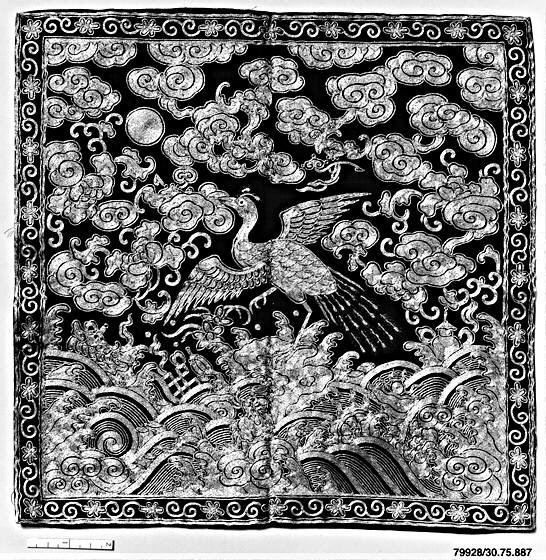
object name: rank badge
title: Rank Badge with Peacock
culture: chinese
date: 1767-1833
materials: metal thread, silk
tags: bats,peacocks